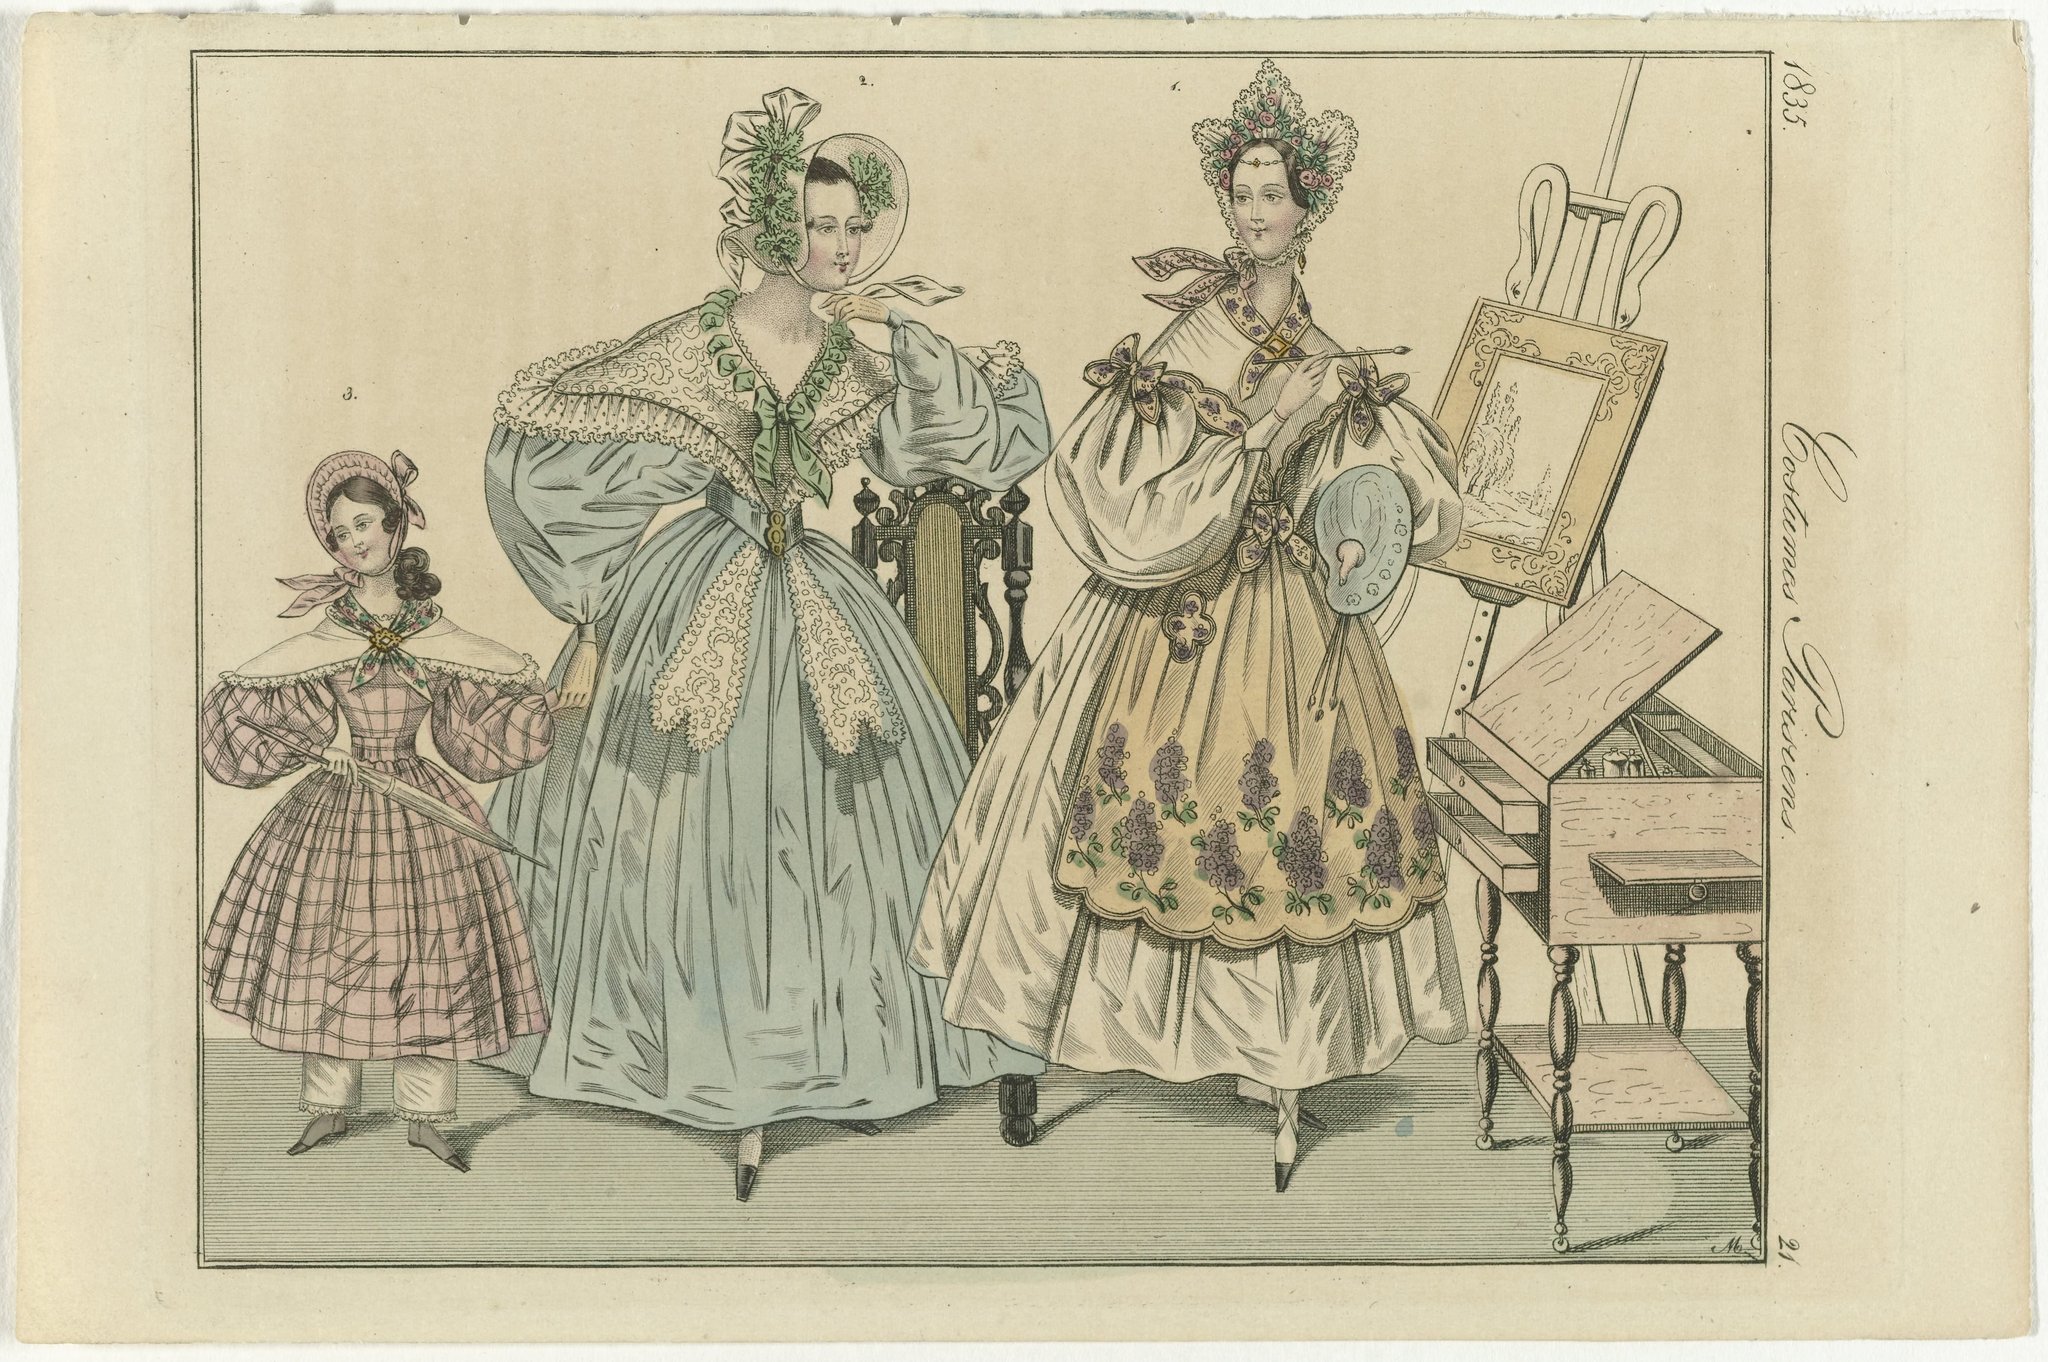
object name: fashion print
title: Journal des Dames et des Modes, editie Frankfurt 1835, Costumes Parisiens, (21)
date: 1835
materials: paper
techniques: engraving, hand coloring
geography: frankfurt am main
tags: walking-stick, staff, cane (+ girls' clothes), underclothes for the lower part of the body: bloomers (+ girls' clothes), head-gear: cap (+ women's clothes), fashion plates, head-gear: hat (+ women's clothes), dress, gown (+ women's clothes), tools, implements of painter, painter at work, in his studio, apron (+ women's clothes), piece of clothing covering the breast or décolleté (fichu) (+ women's clothes), dress, gown (+ girls' clothes)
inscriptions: title: ‘Costumes Parisiens’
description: Een vrouw staat bij een schildersezel met palet en kwasten in de handen. Zij draagt een japon en een schort met bloemmotief. Naast de ezel staat een kast met schildersbenodigdheden. Een vrouw in japon met fichu staat naast haar. Luifelhoed op het hoofd. Meisje in geruite japon en bloomers. Parasol of paraplu in de hand. Prent uit het modetijdschrift Journal des Dames et des Modes (Frankfurt-am-Main, 1798-1848). Het meisje is waarschijnlijk overgenomen uit de Franse editie van Journal des Dames et des Modes.